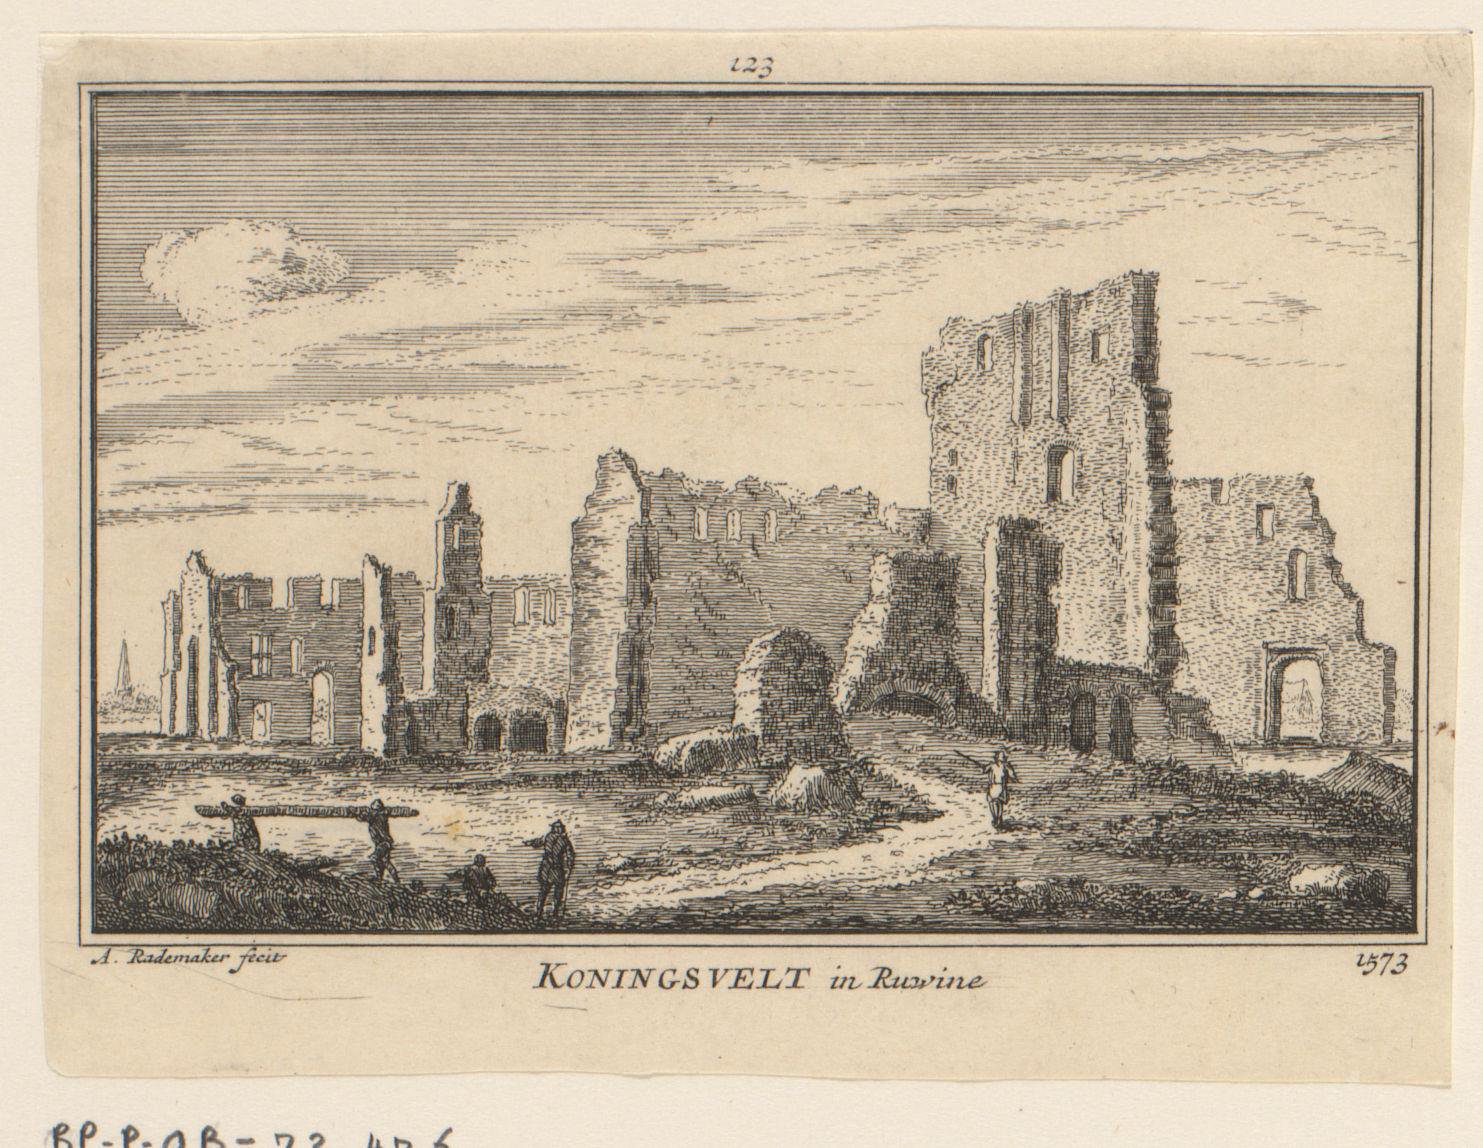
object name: print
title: Gezicht op de ruïne van het klooster Koningsveld, 1573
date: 1727-1733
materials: paper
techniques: etching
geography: amsterdam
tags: ruin of church, monastery, etc.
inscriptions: collector's mark: Lugt 2228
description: Illustratie uit: Abraham Rademaker, Matthaeus Brouërius van Niedek, Isaac Le Long, Kabinet van Nederlandsche en Kleefsche outheden en (...) voorname stads- en landgebouwen, Willem Barents en Antoni Schoonenburg: Amsterdam, 1727-1733, ill. nr. 123.